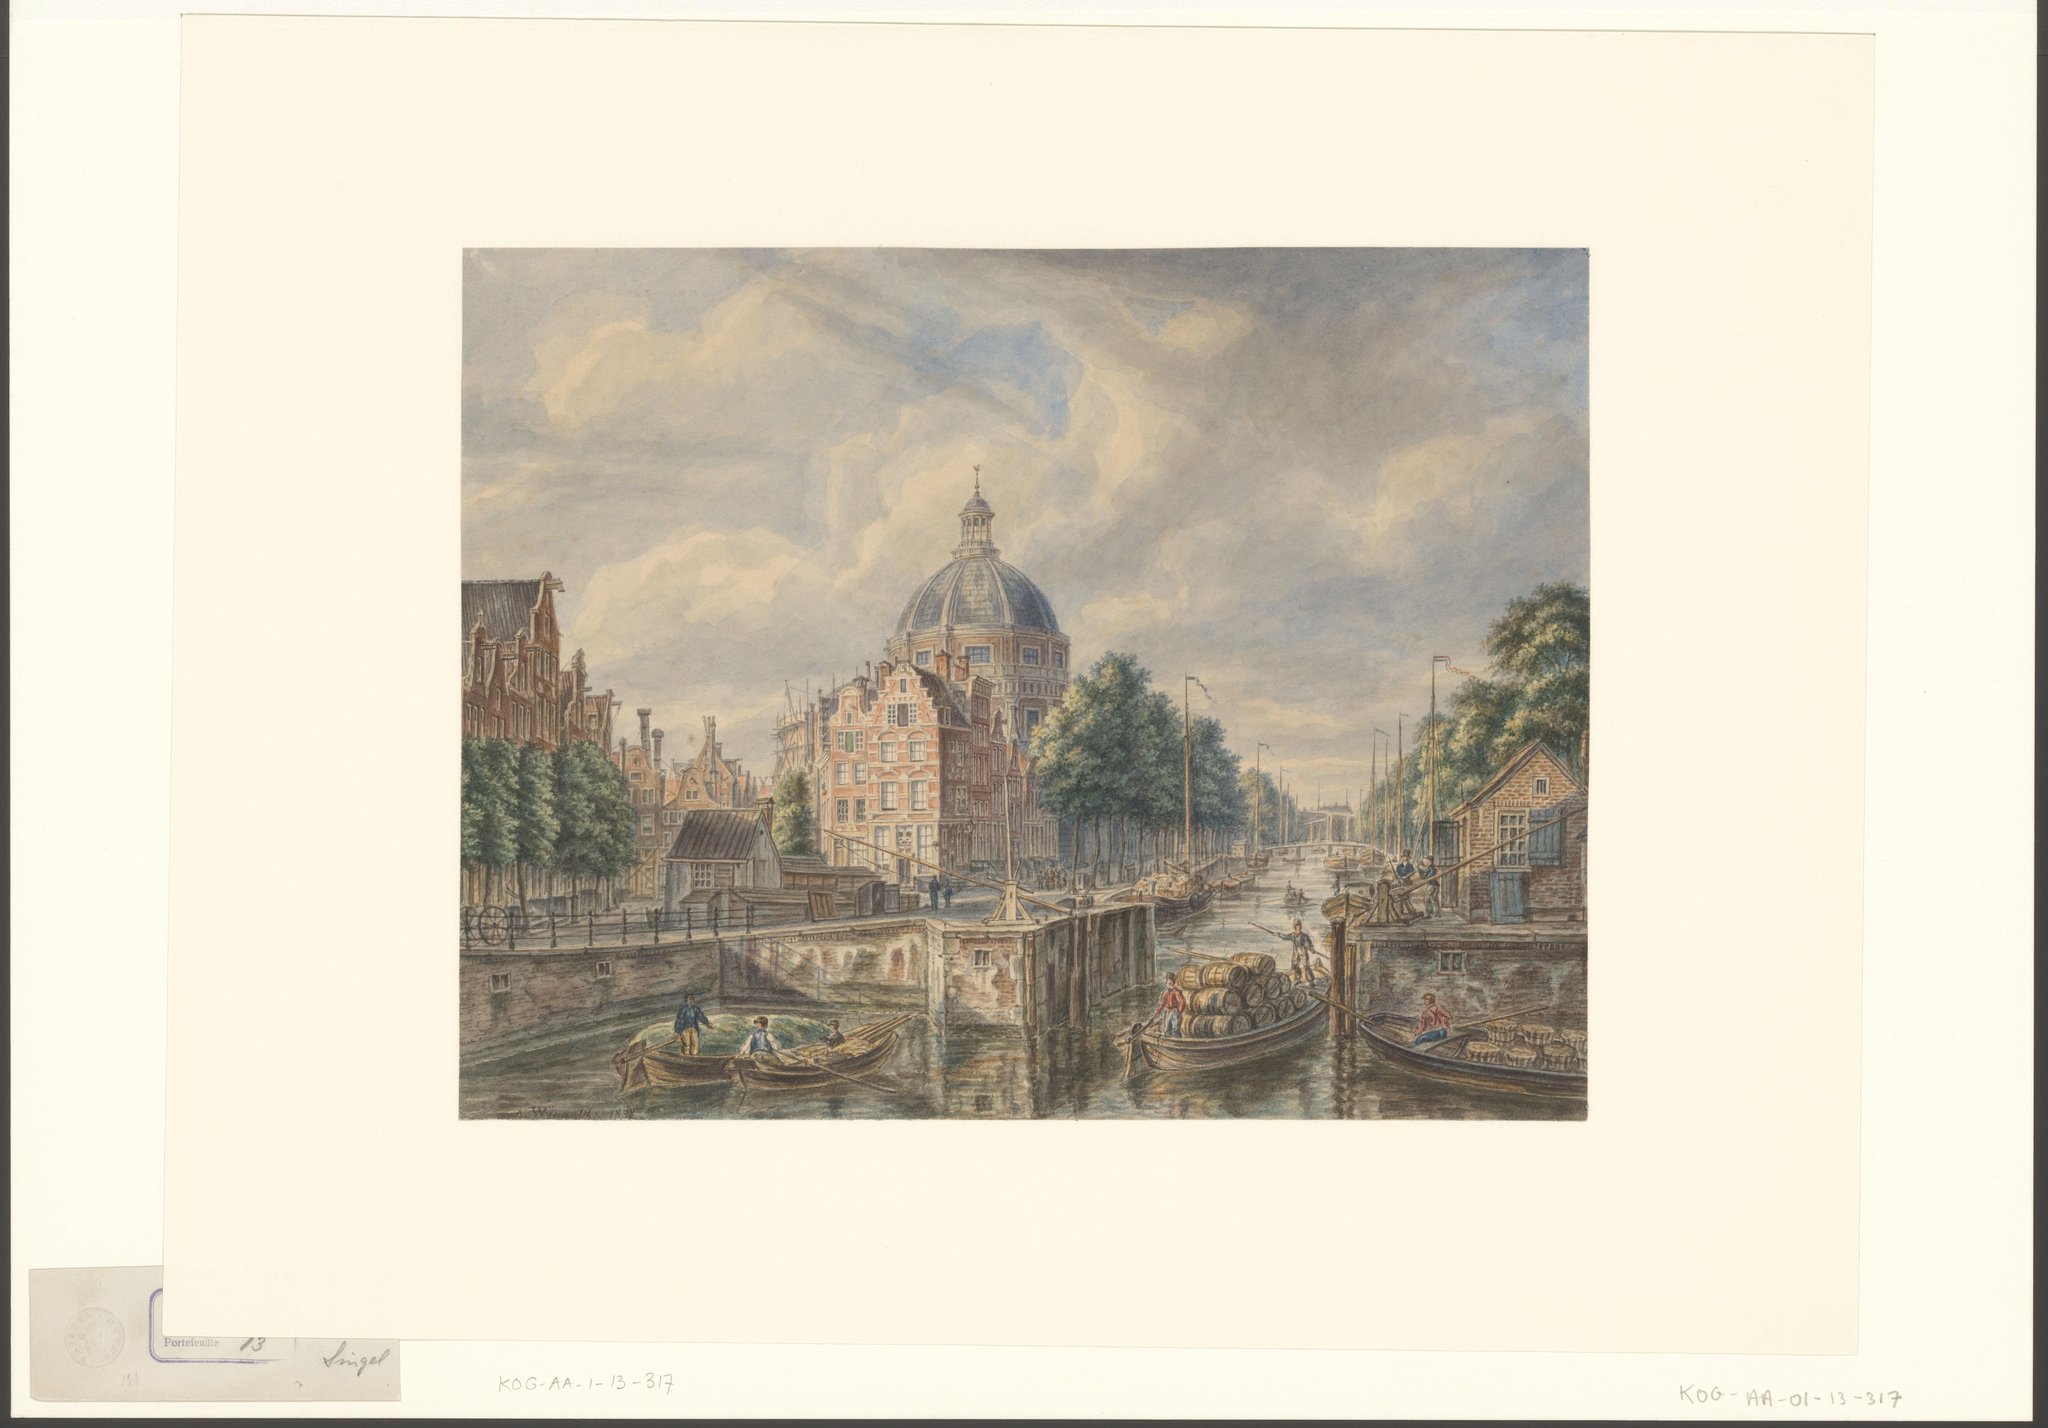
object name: drawing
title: Gezicht op de Haarlemse Sluis en de Ronde Lutherse Kerk aan het Singel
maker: augustus wijnantz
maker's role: draughtsman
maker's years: 1795-1848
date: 1838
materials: ink, paper, pencil, watercolor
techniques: brush, pen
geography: amsterdam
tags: city-view in general; 'veduta', parts of church exterior and annexes: dome, canal, street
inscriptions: inscription: ‘Port. 13-317’, signature and date: ‘A. Wijnantz. 1838.’, collector's mark: ‘13’ Lugt 1641b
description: Onderwerpsrubriek binnen de Atlas Amsterdam: Oude Schans, Schoutensteeg, Singel (Korte), Singel.